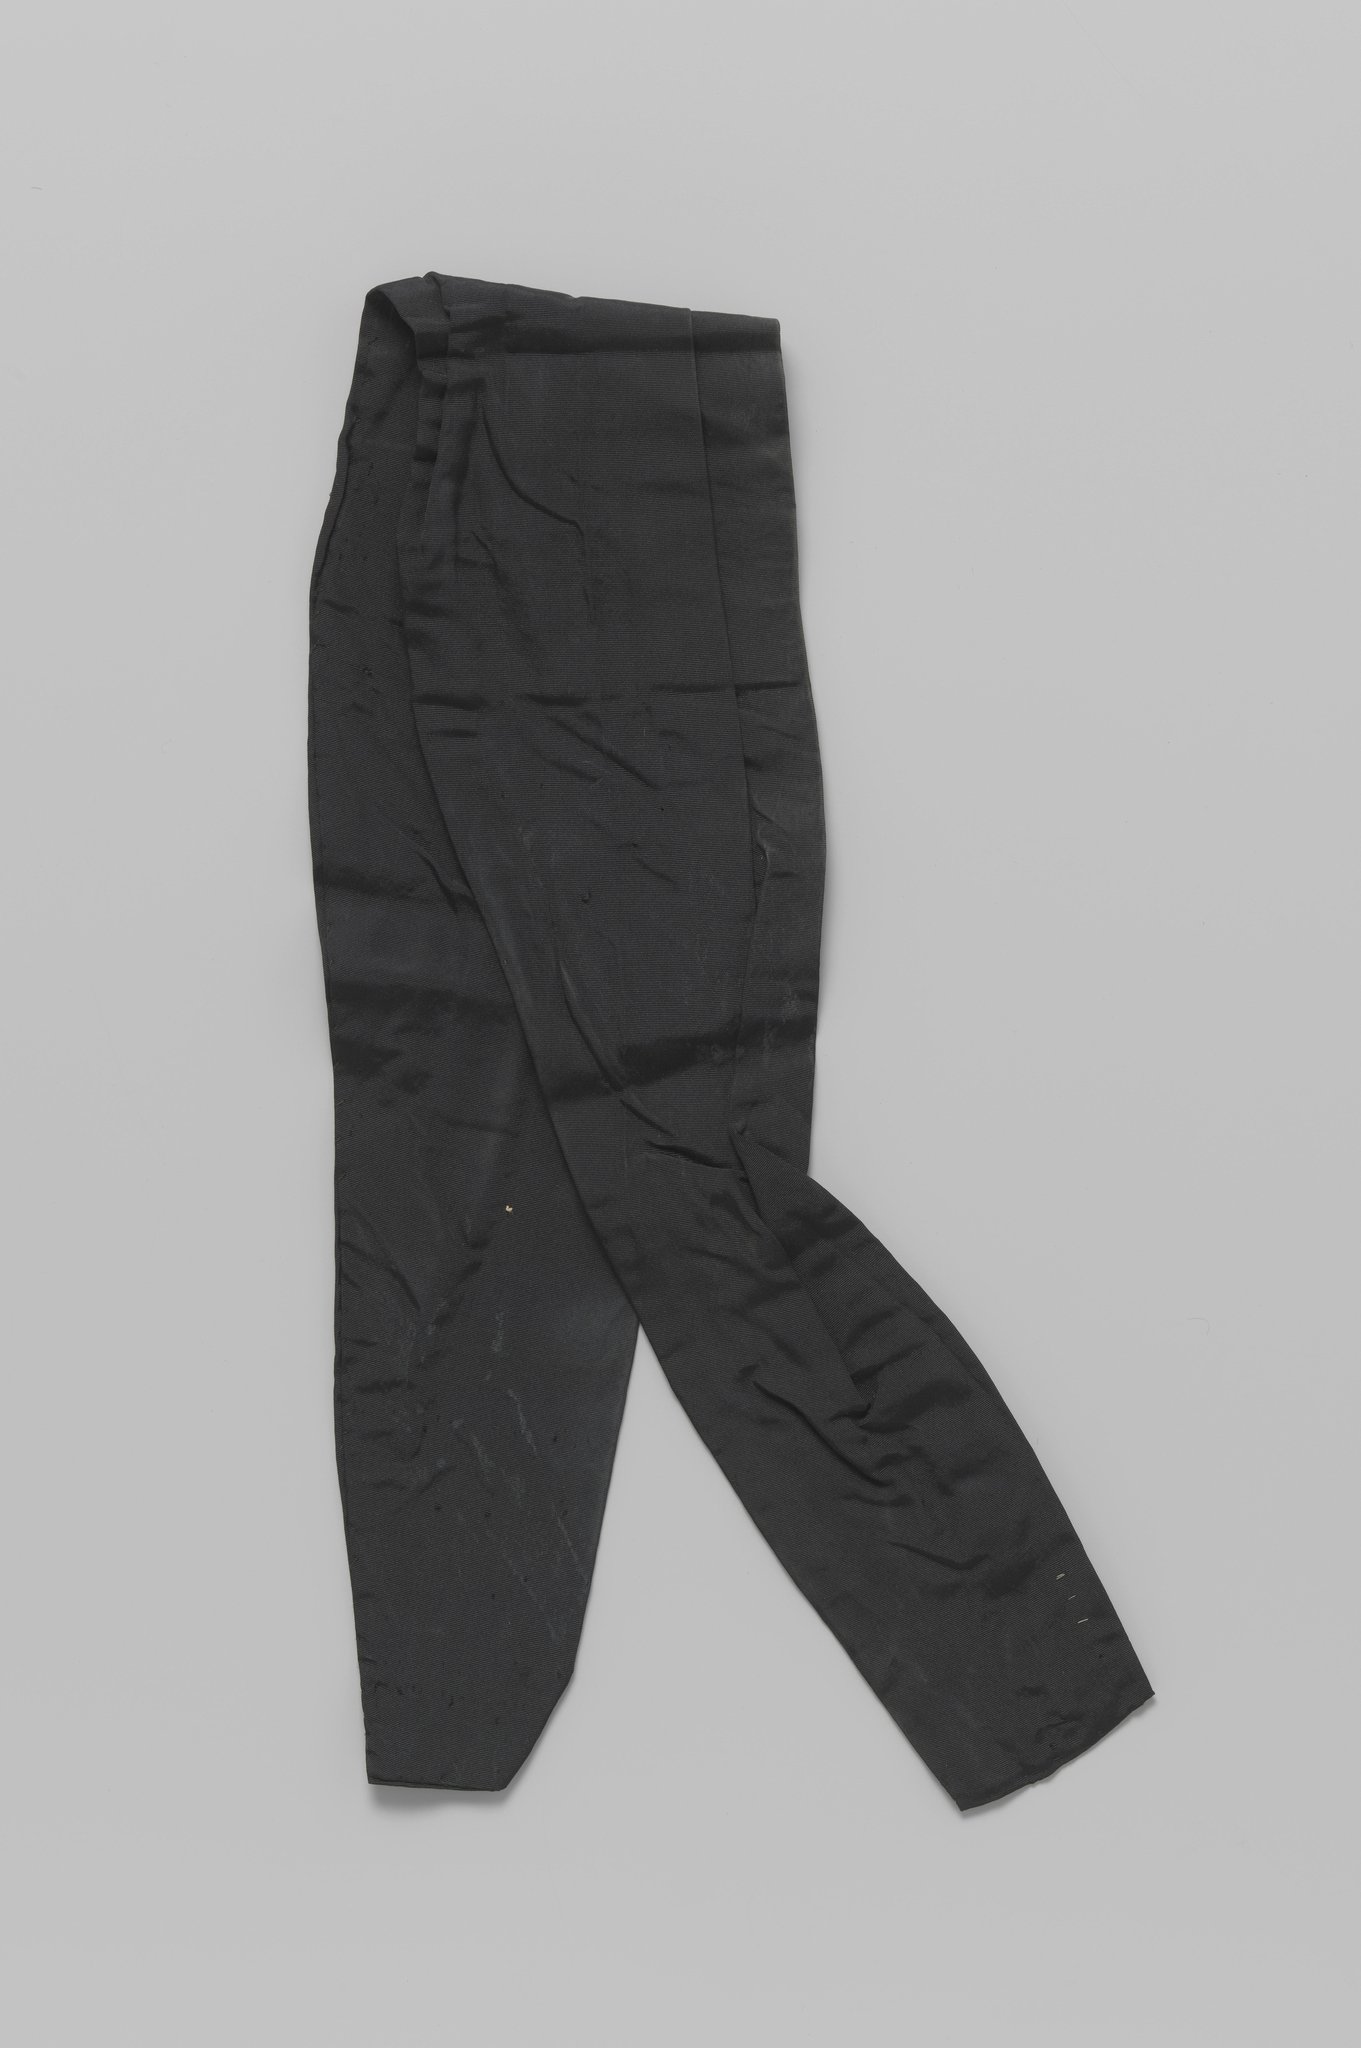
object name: menswear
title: Herendas van zwarte ripszijde, opgebouwd uit twee lagen stof, waarvan de buitenste onderaan in een lange gebogen plooi is gelegd, de binnenste is glad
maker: Anonymous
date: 1800-1820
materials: silk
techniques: sewing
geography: amsterdam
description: Herendas van zwarte ripszijde, opgebouwd uit twee lagen stof, waarvan de buitenste onderaan in een lange gebogen plooi is gelegd, de binnenste is glad.